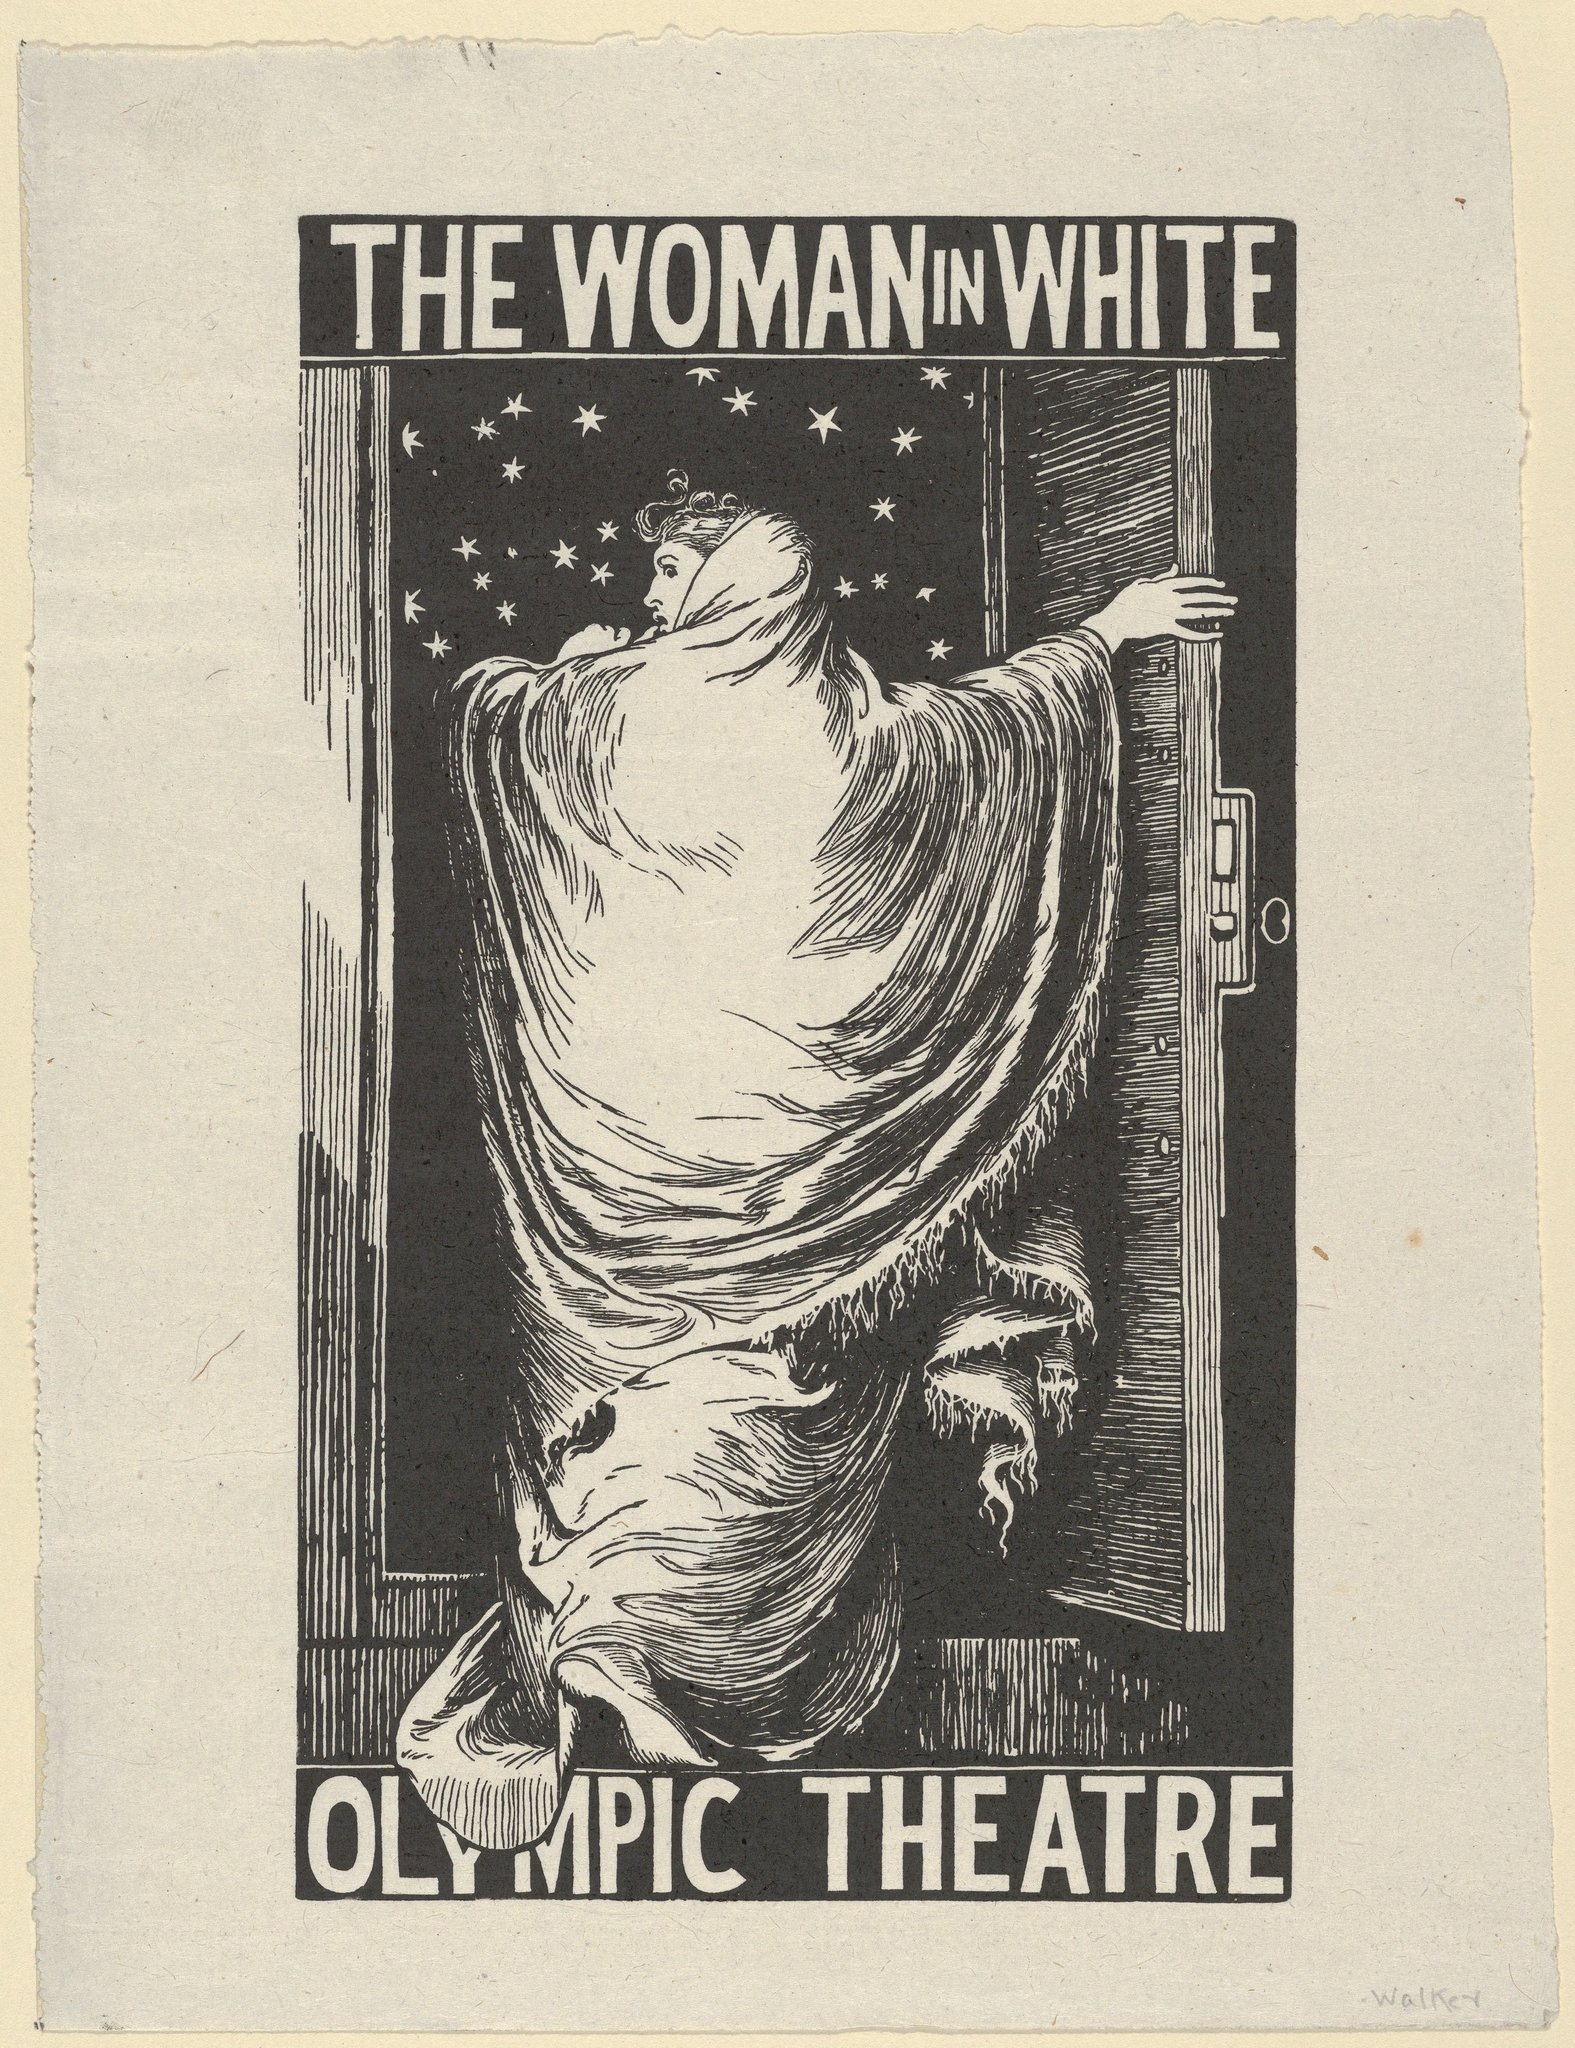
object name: print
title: The Woman in White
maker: william harcourt hooper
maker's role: engraver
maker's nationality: british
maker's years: 1834-1912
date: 1871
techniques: engraving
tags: theatre,women,advertisements